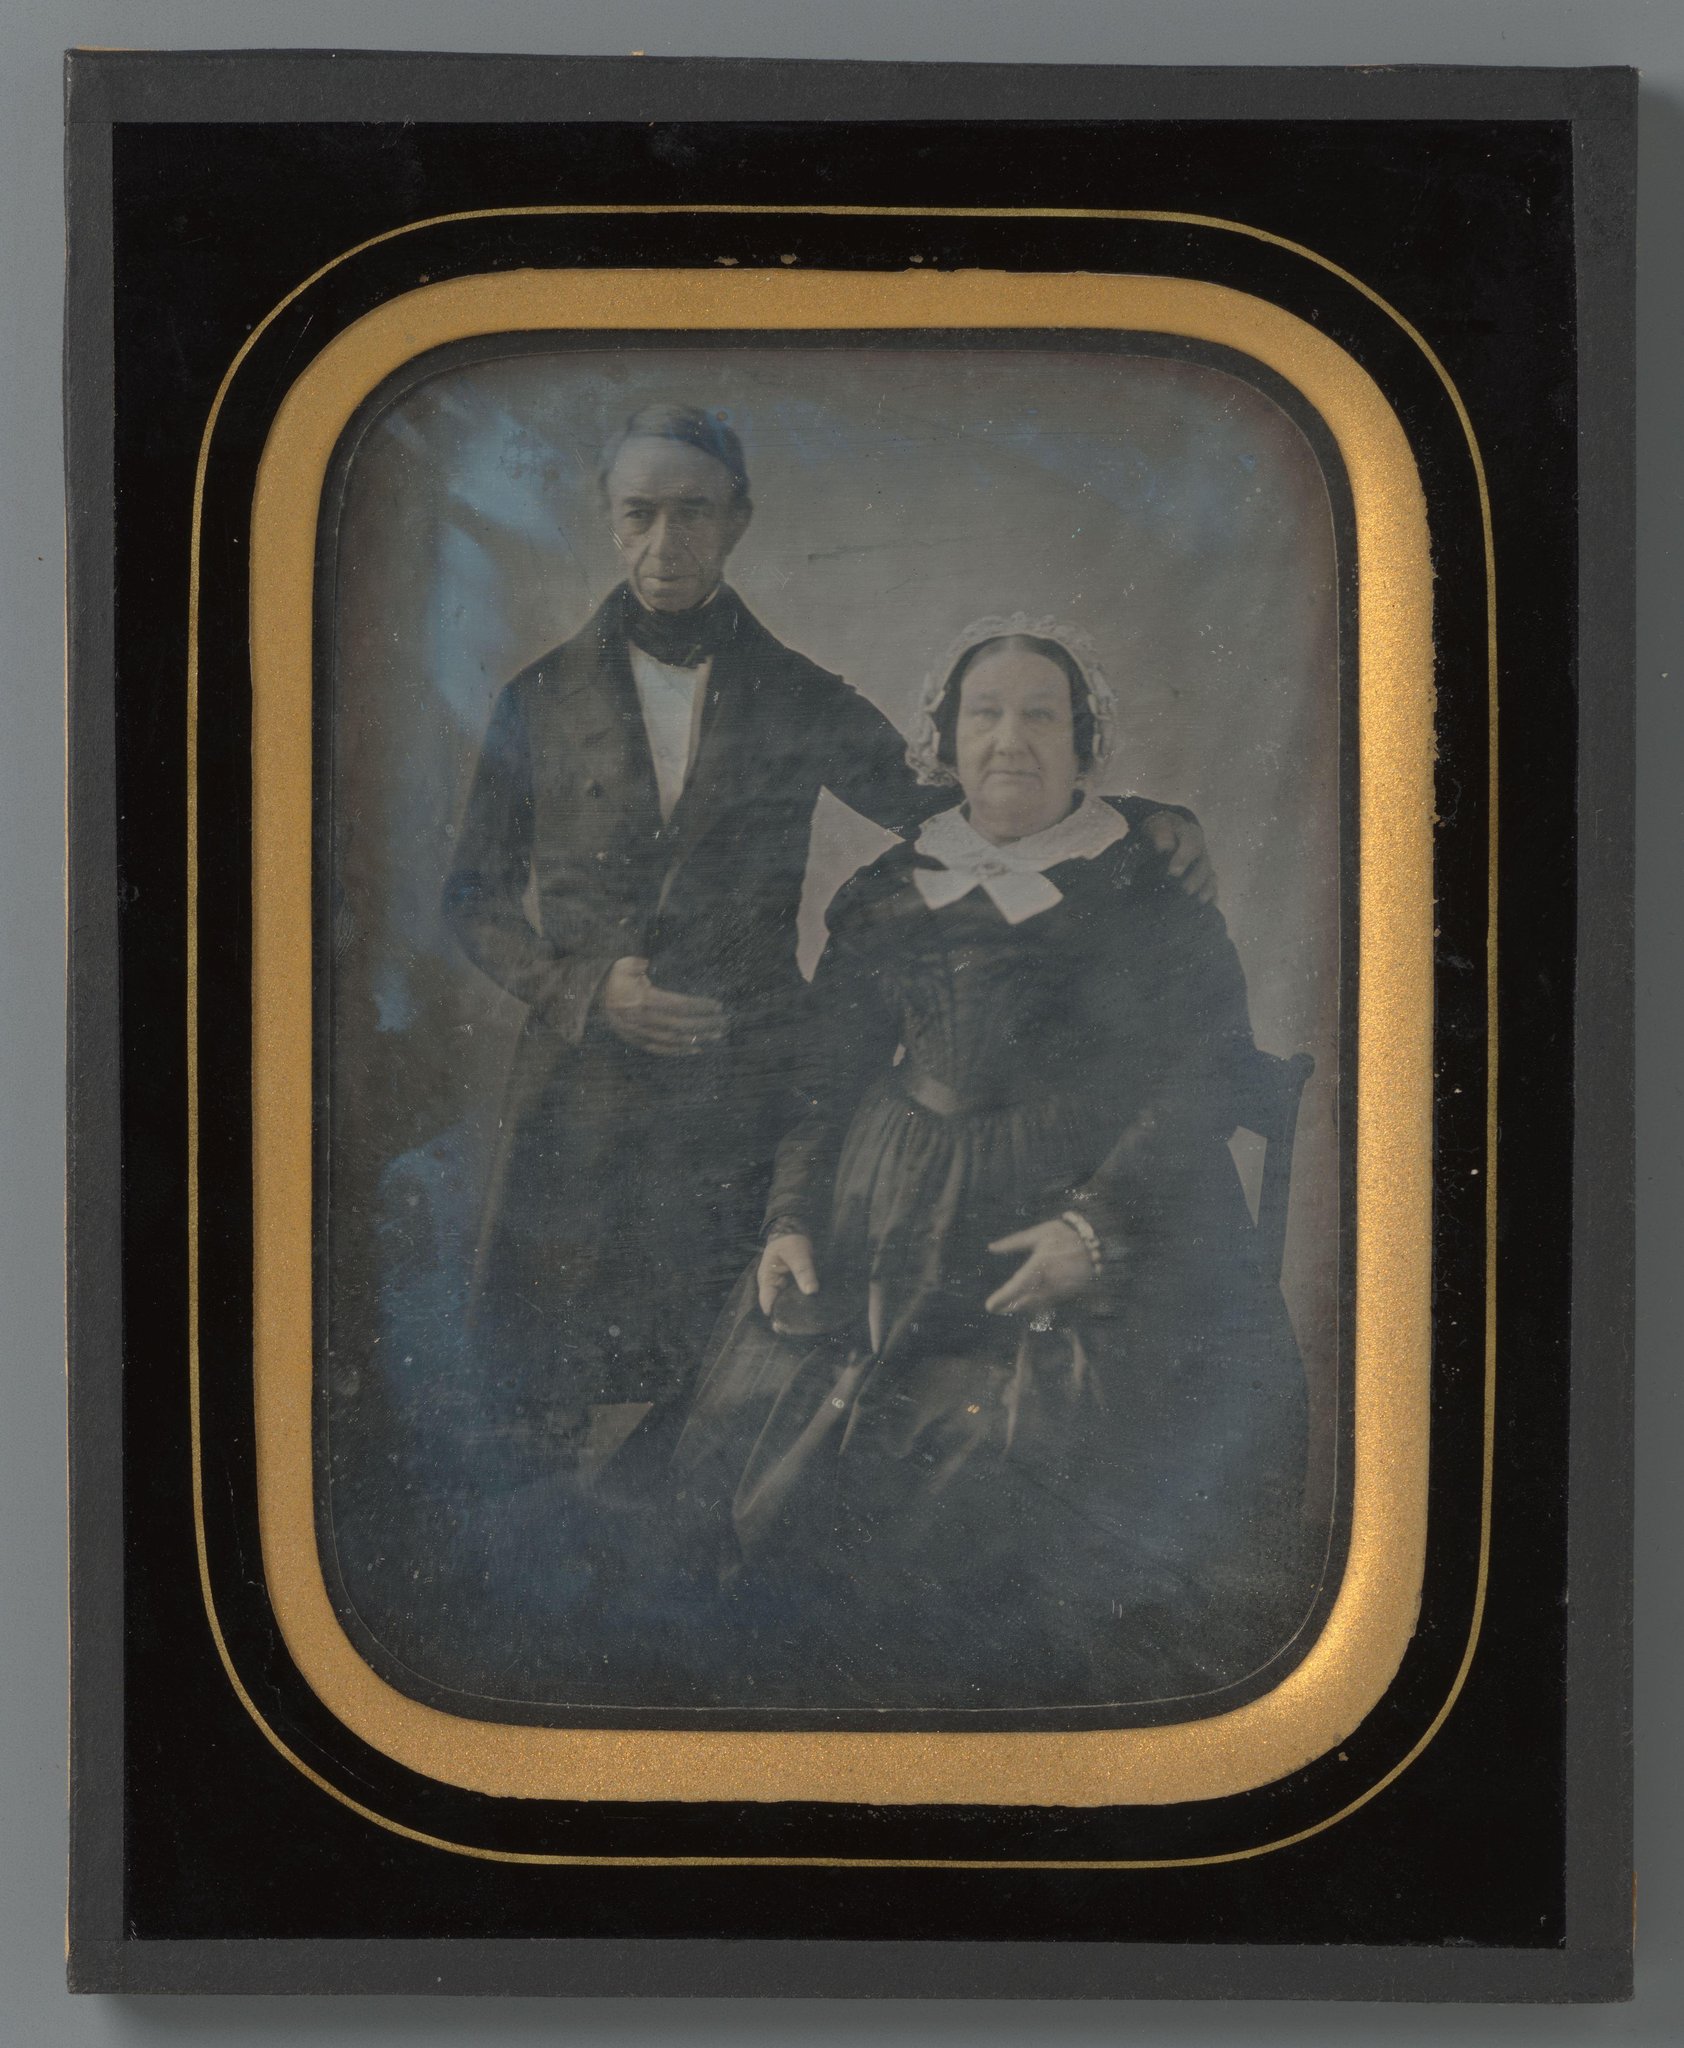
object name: photograph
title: Portret van Johannes Franciscus Borghmans en zijn vrouw Maria Geertruida Swemer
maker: Anonymous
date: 1849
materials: copper, silver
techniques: daguerreotype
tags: antwerp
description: Foto in lijstje. Johannes Franciscus Borghmans was vice-consul Frankrijk en consulair agent Rusland.